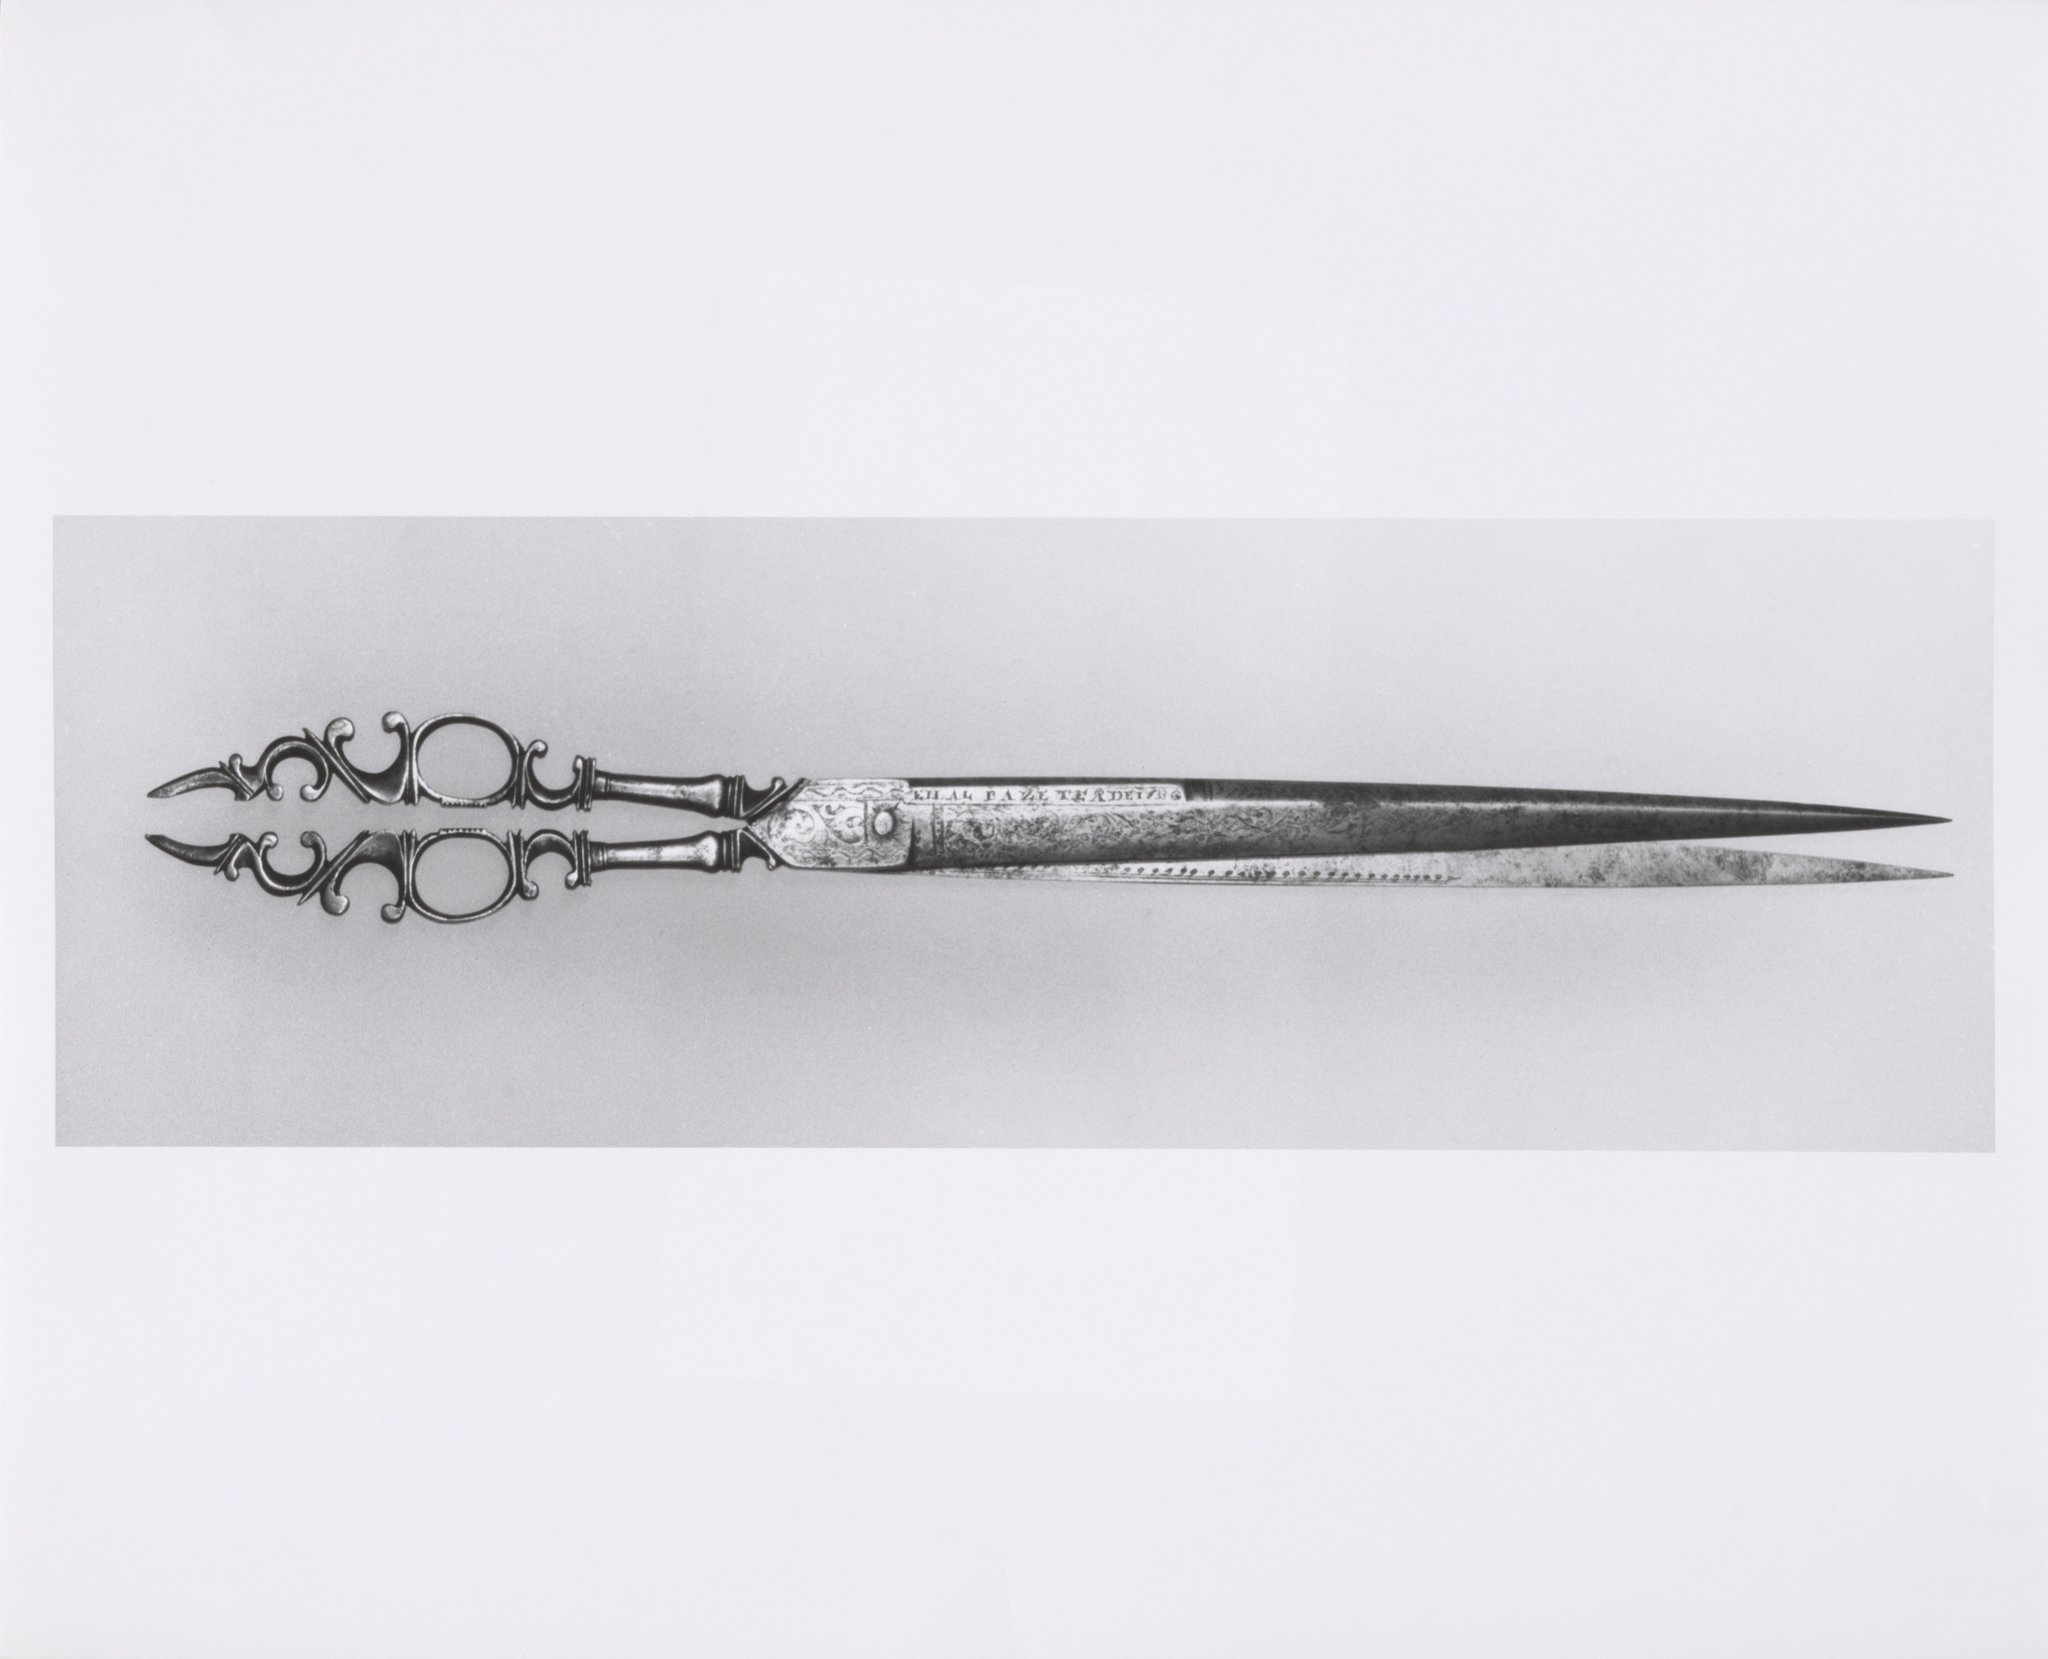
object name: scissors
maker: gabriel de la vega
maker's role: maker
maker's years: 1675-1775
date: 1733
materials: steel